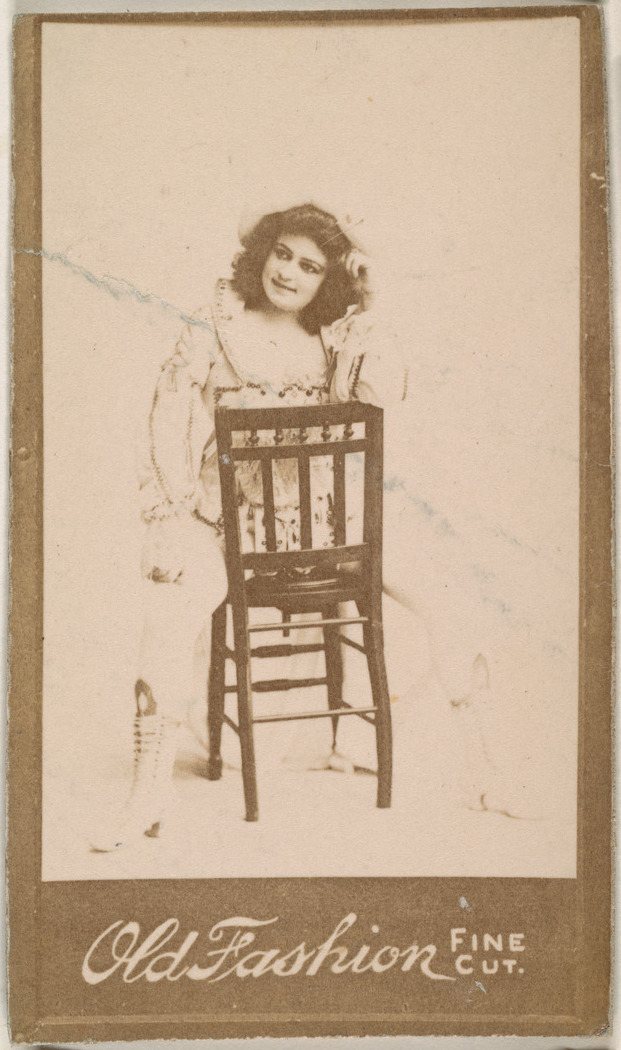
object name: photograph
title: Actress straddling chair, from the Actresses series (N664) promoting Old Fashion Fine Cut Tobacco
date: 1888-1890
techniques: albumen silver print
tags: portraits,women,actresses